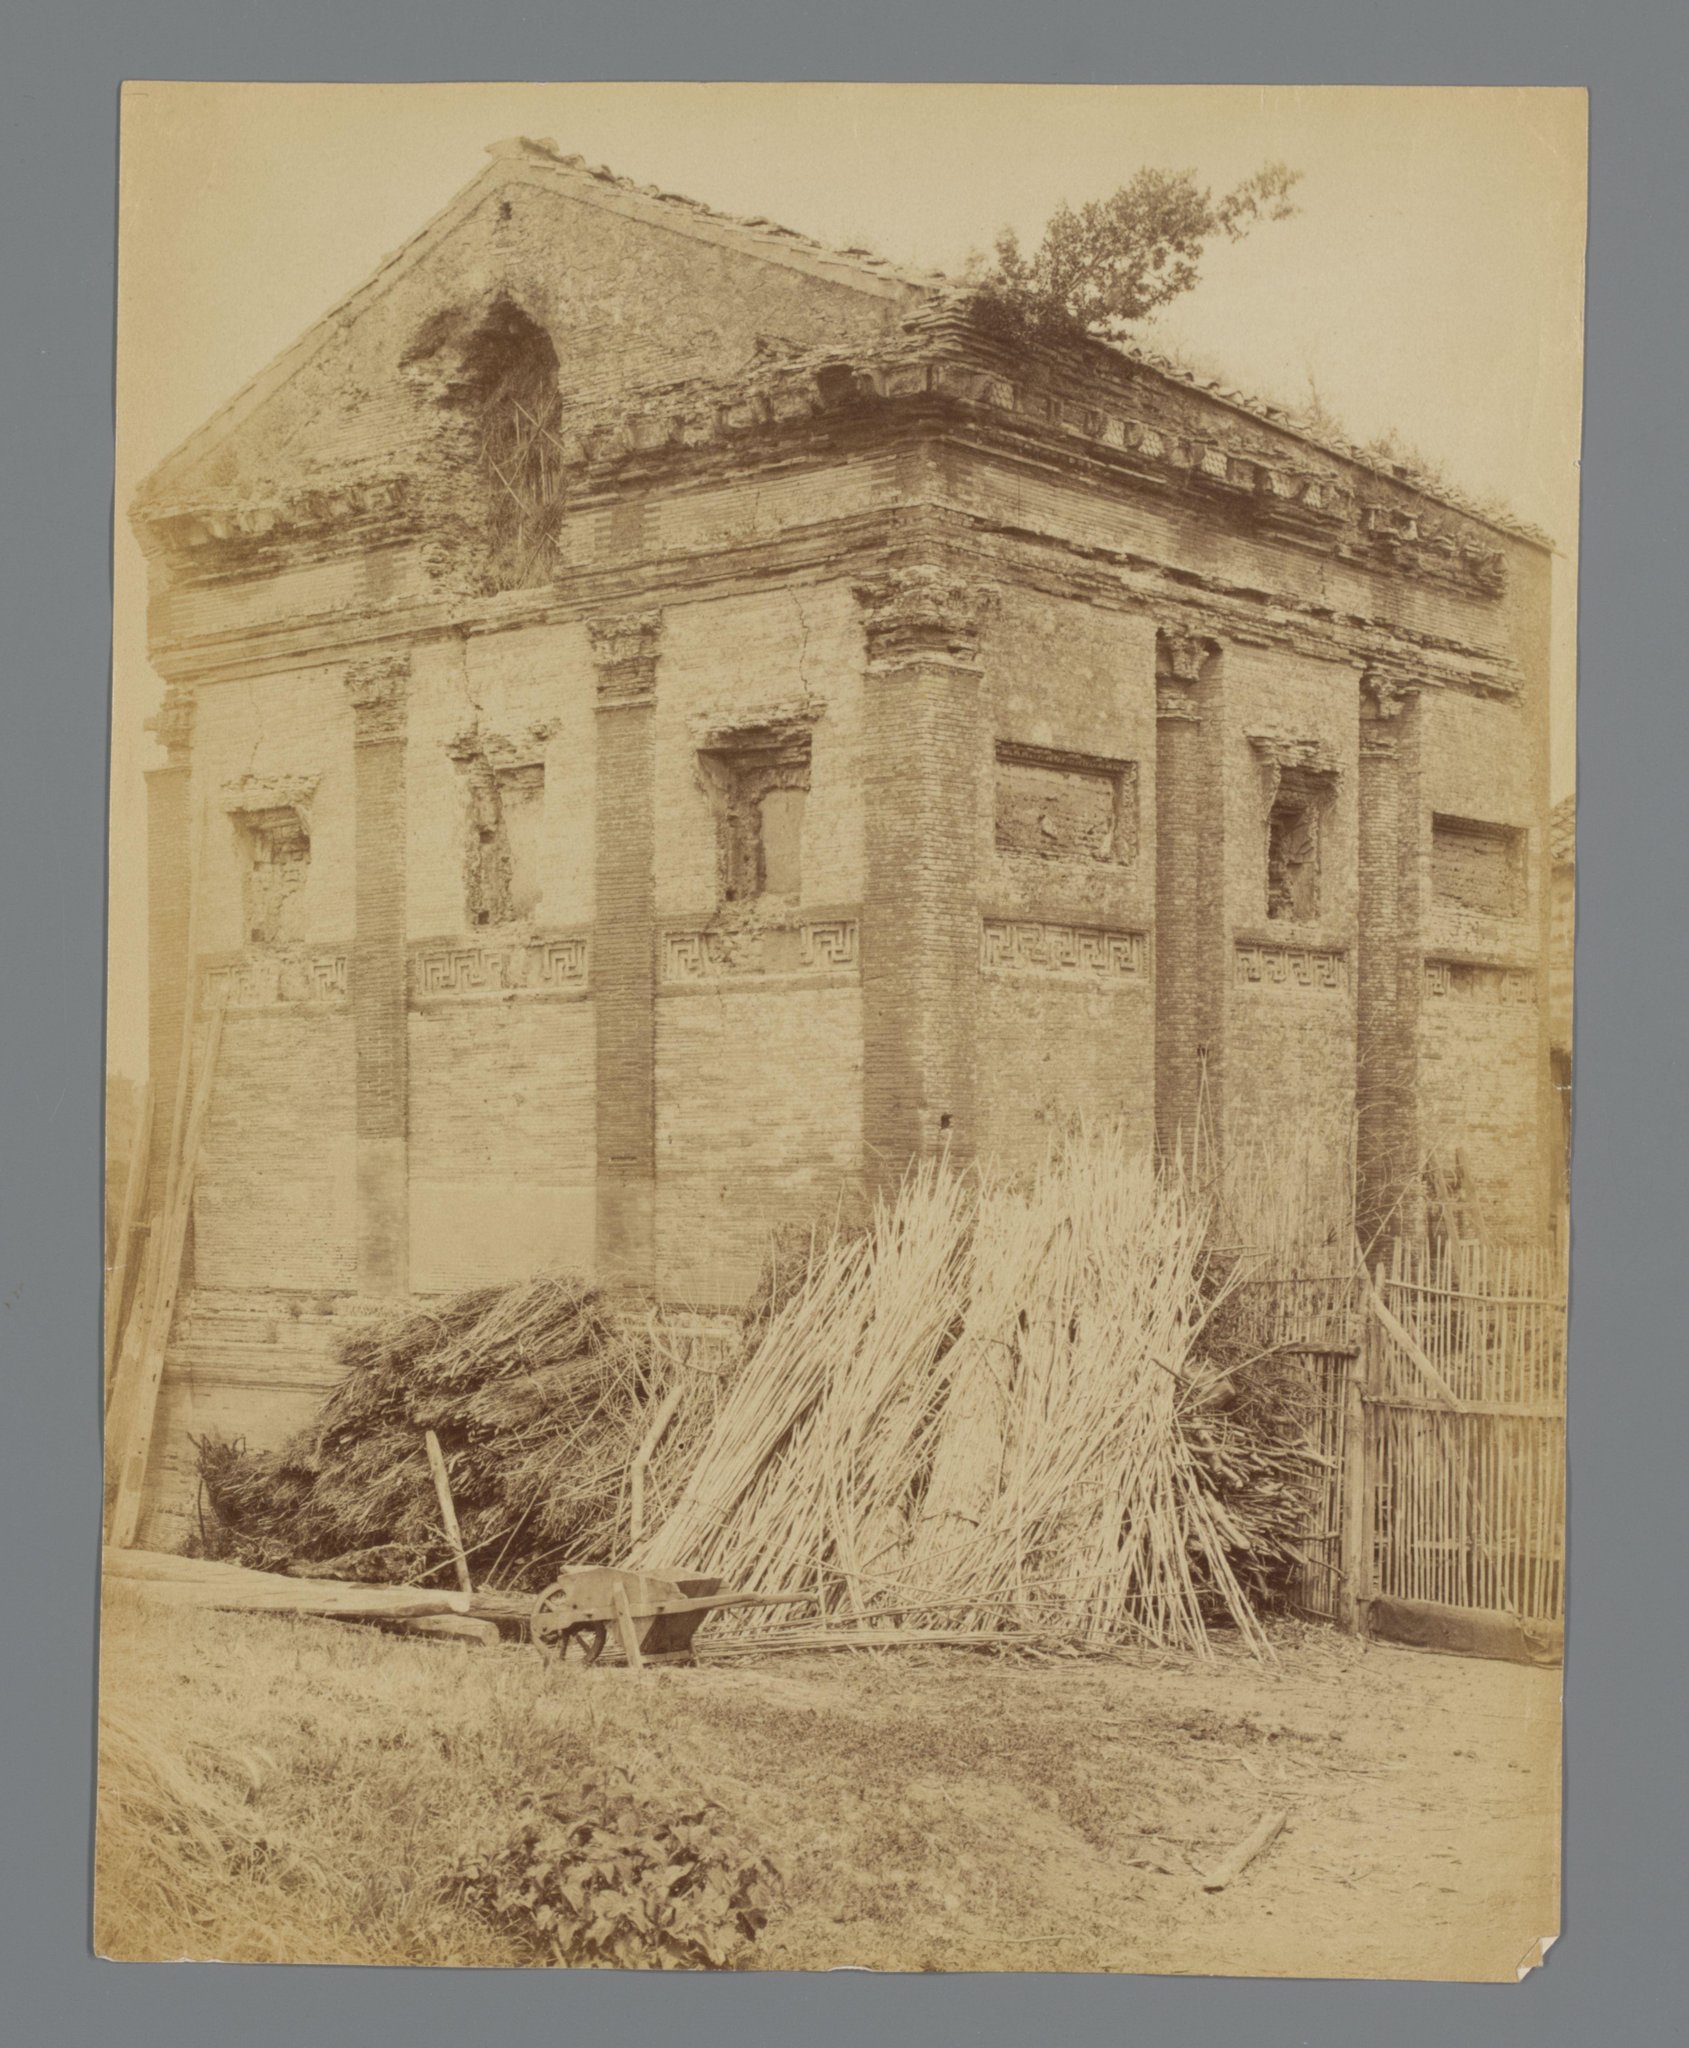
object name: photograph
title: Ruïne van een gebouw in Rome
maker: Anonymous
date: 1851-1900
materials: paper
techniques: albumen print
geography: rome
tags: ruin of a building ~ architecture, rome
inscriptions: collector's mark: ‘VOSMAER’, inscription: ‘Roma/ Tempel Jupiter reticulus (grufo) [?]’